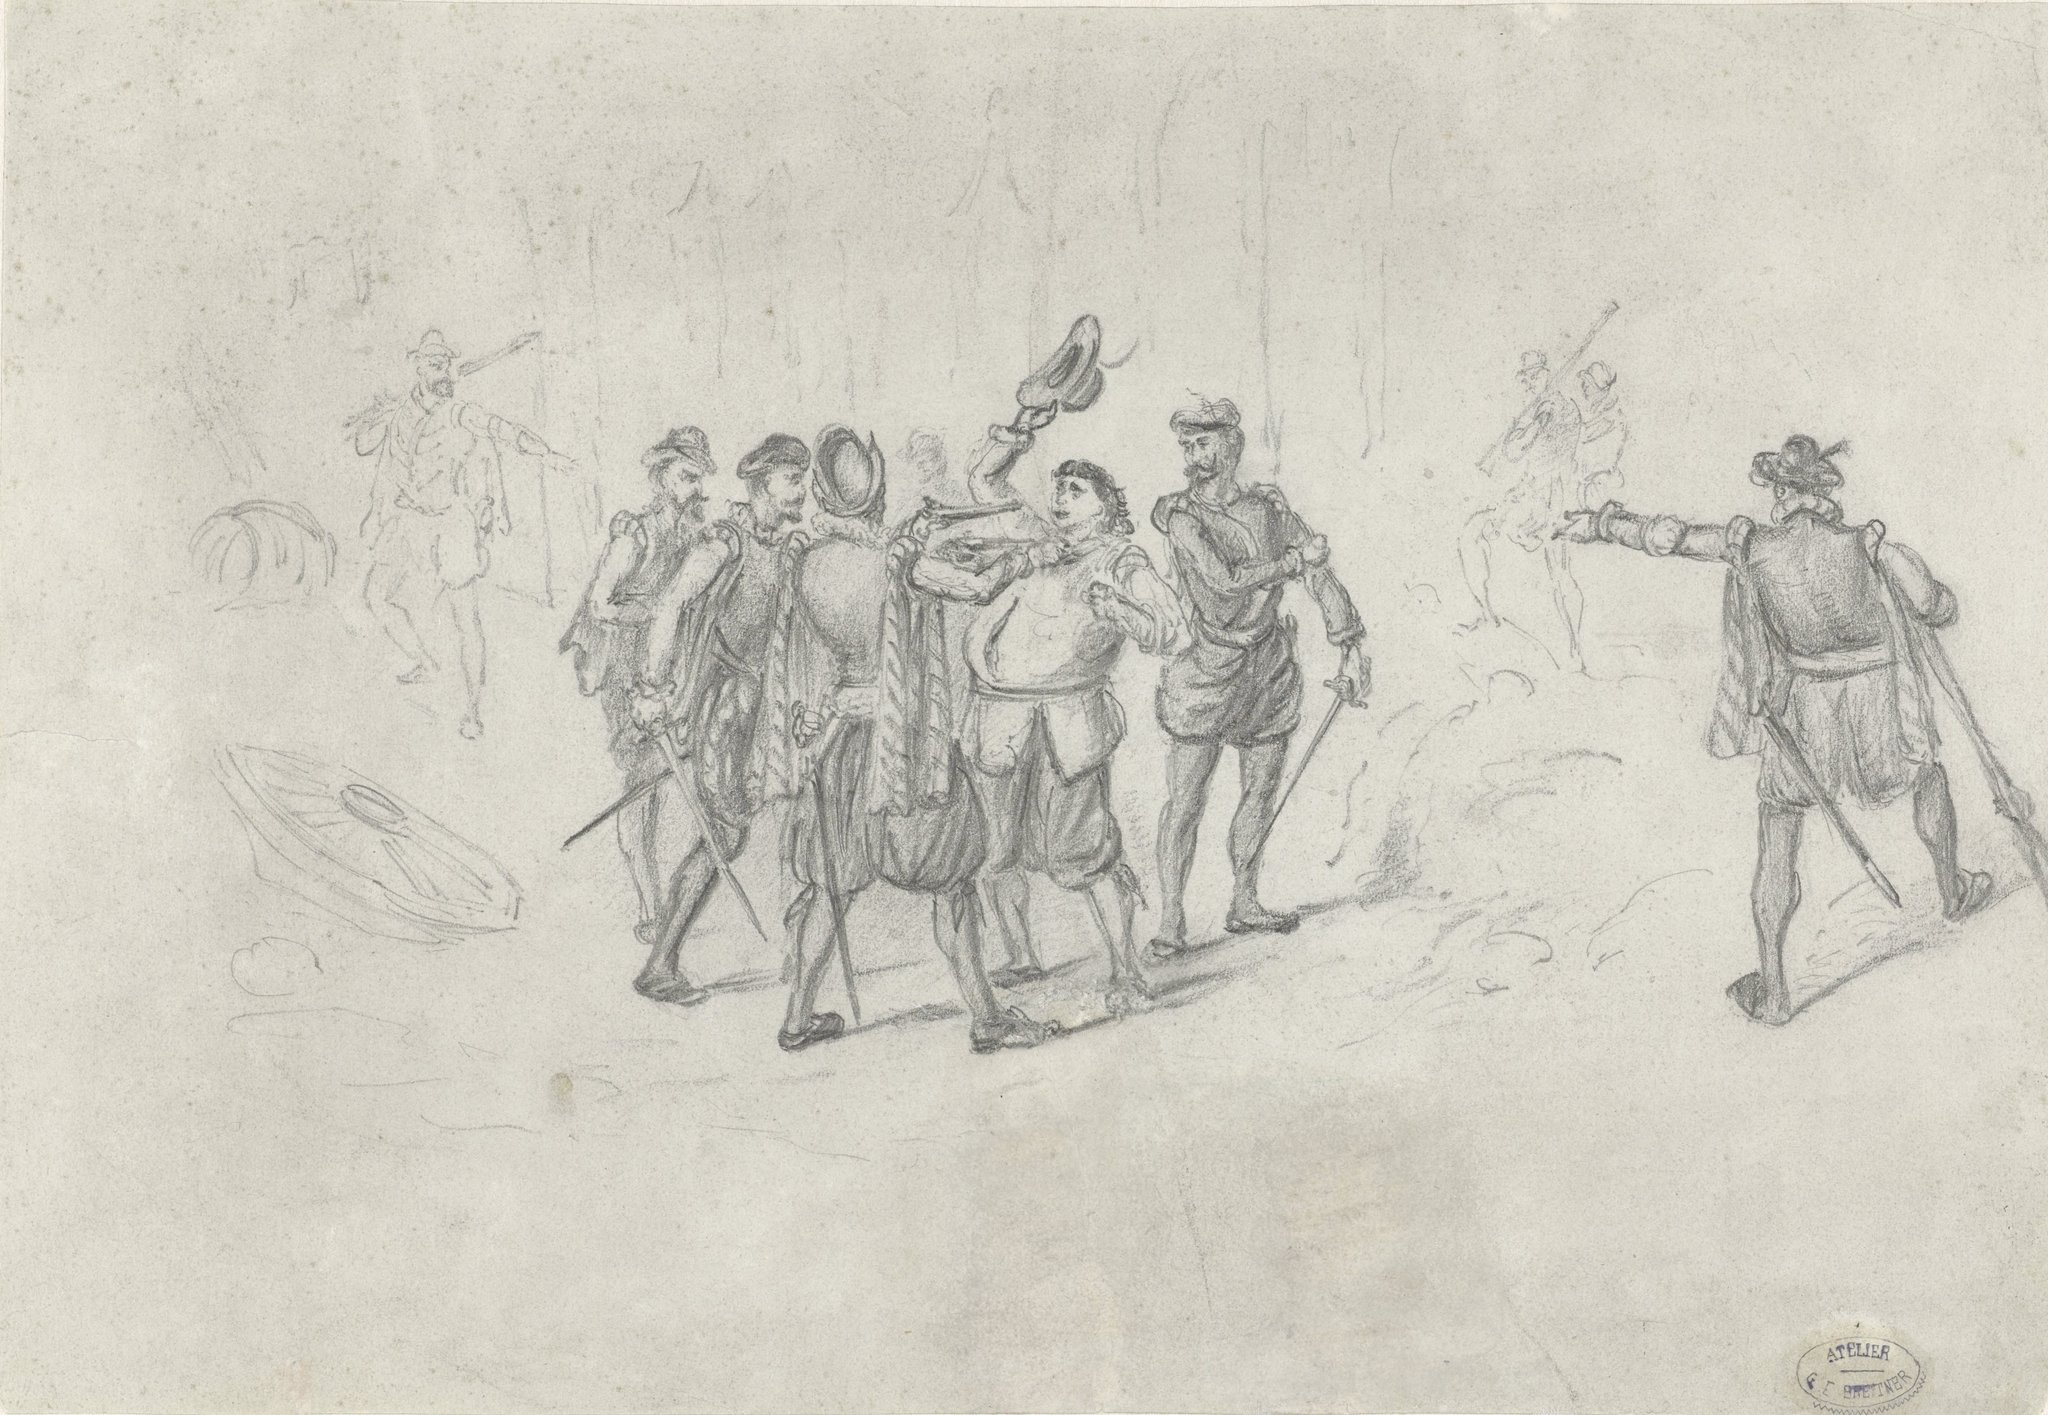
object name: drawing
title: Historische voorstelling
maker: george hendrik breitner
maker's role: draughtsman, painter, print maker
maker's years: 1857-1923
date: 1867-1923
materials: chalk, paper, pencil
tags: arrest (of criminal)